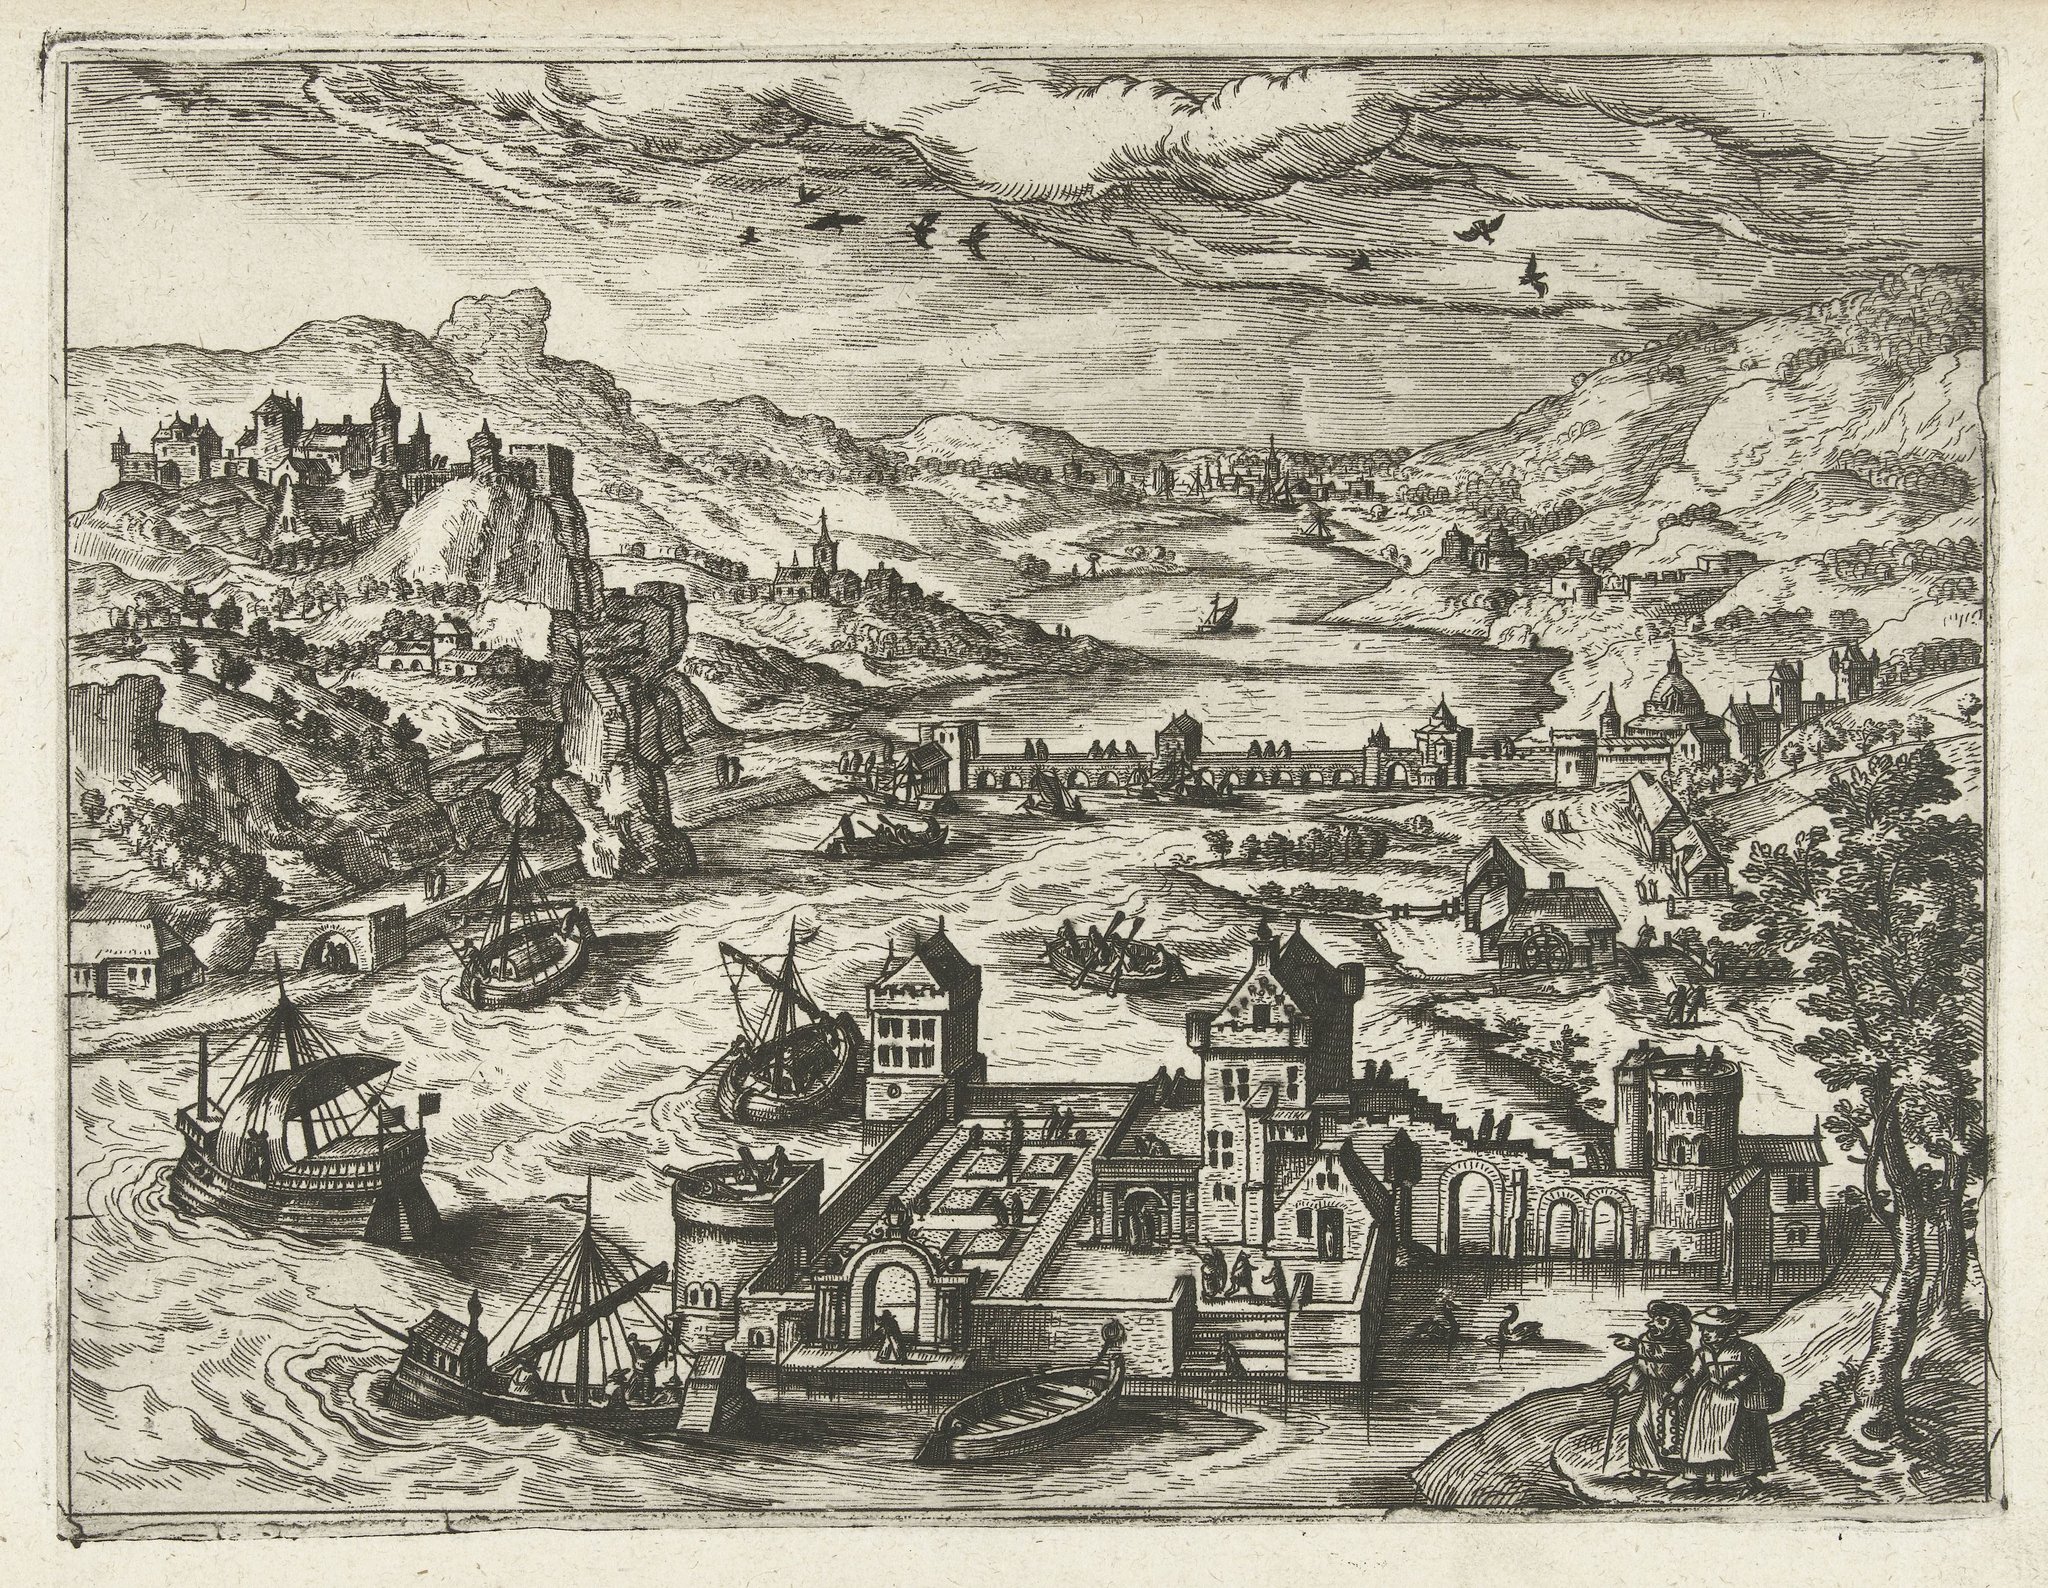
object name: print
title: Landschappen, zeegezichten en fantasierijke stadsgezichten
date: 1570-1580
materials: paper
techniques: engraving, etching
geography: antwerp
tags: landscape with bridge, viaduct or aqueduct, landscape with tower or castle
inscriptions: number: ‘131’, collector's mark: Lugt 2760, collector's mark: Lugt 2228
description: In een heuvelachtig landschap stroomt een rivier waarin verschillende schepen varen. Op de linkeroever een dorp op een heuvel, rechts op de voorgrond een waterburcht. Op de achtergrond een stenen brug.